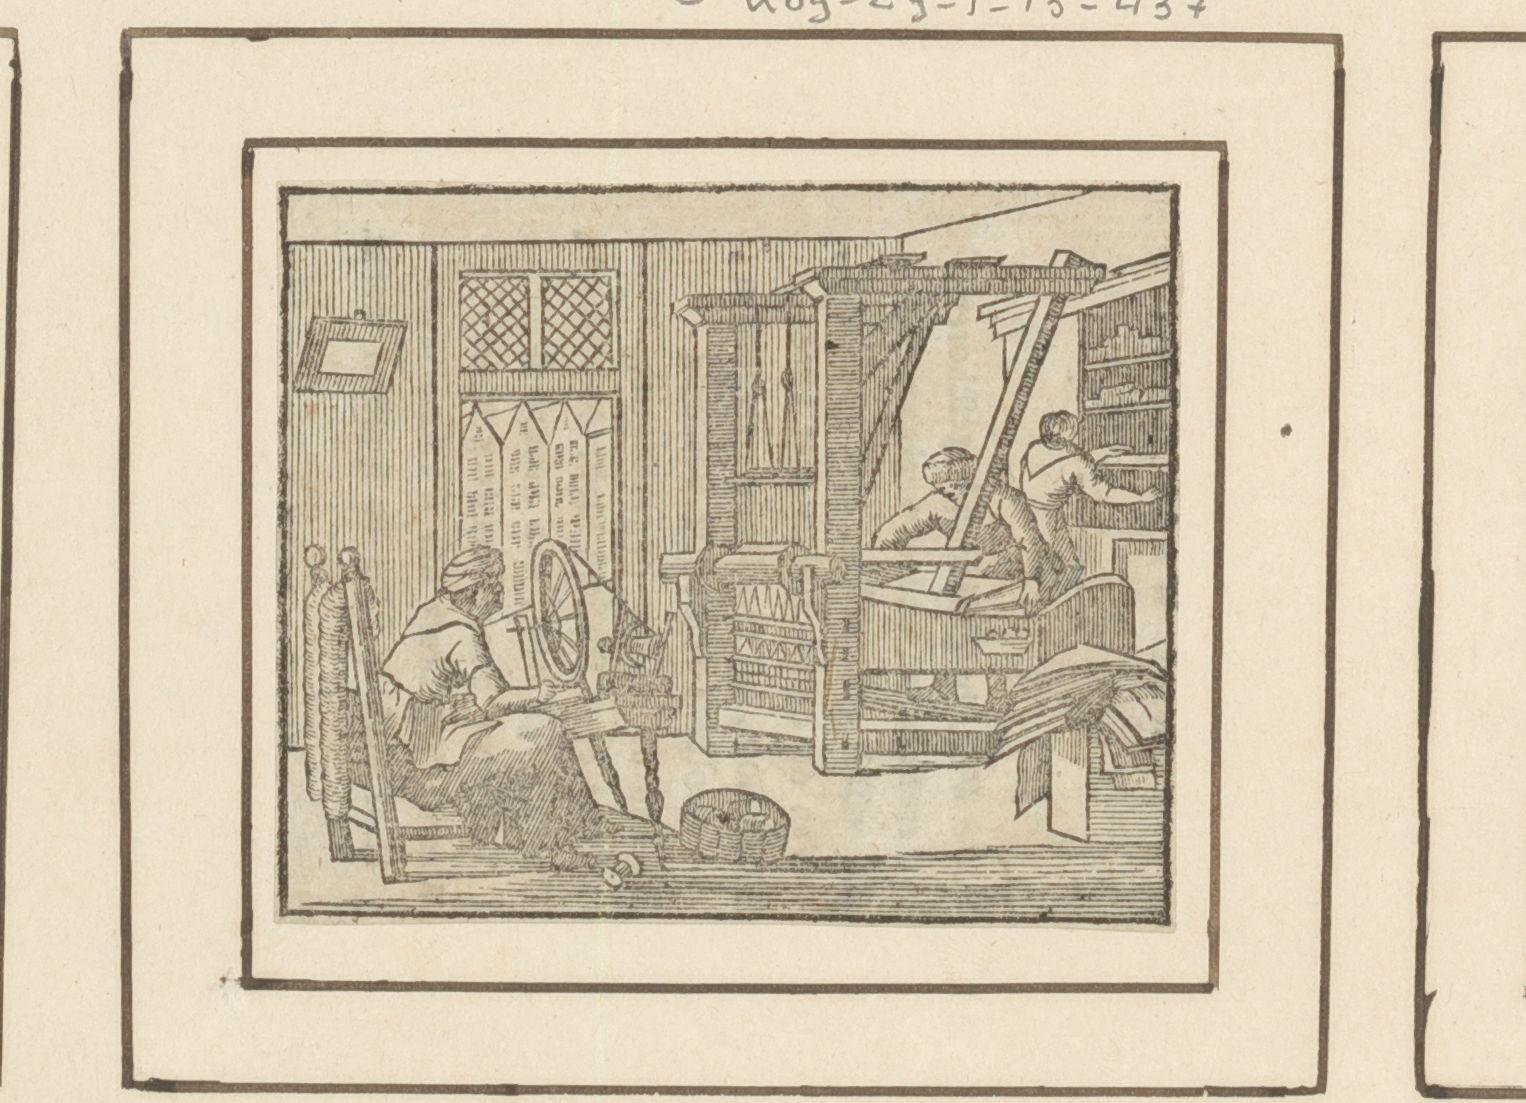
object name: print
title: Spinnen van wol en het weven van laken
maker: Anonymous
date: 1815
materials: paper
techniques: letterpress printing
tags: special processes for woollen fabric, wool (material ~ textile industry)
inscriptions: stamp, stamp, collector's mark: Lugt 1641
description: Onderwerpsrubrieken binnen de Atlas Zeden en Gewoonten: Handel, Nijverheid en verkeer, Beroep en bedrijf, Mannelijk, Lakenindustrie en aanverwante vakken.